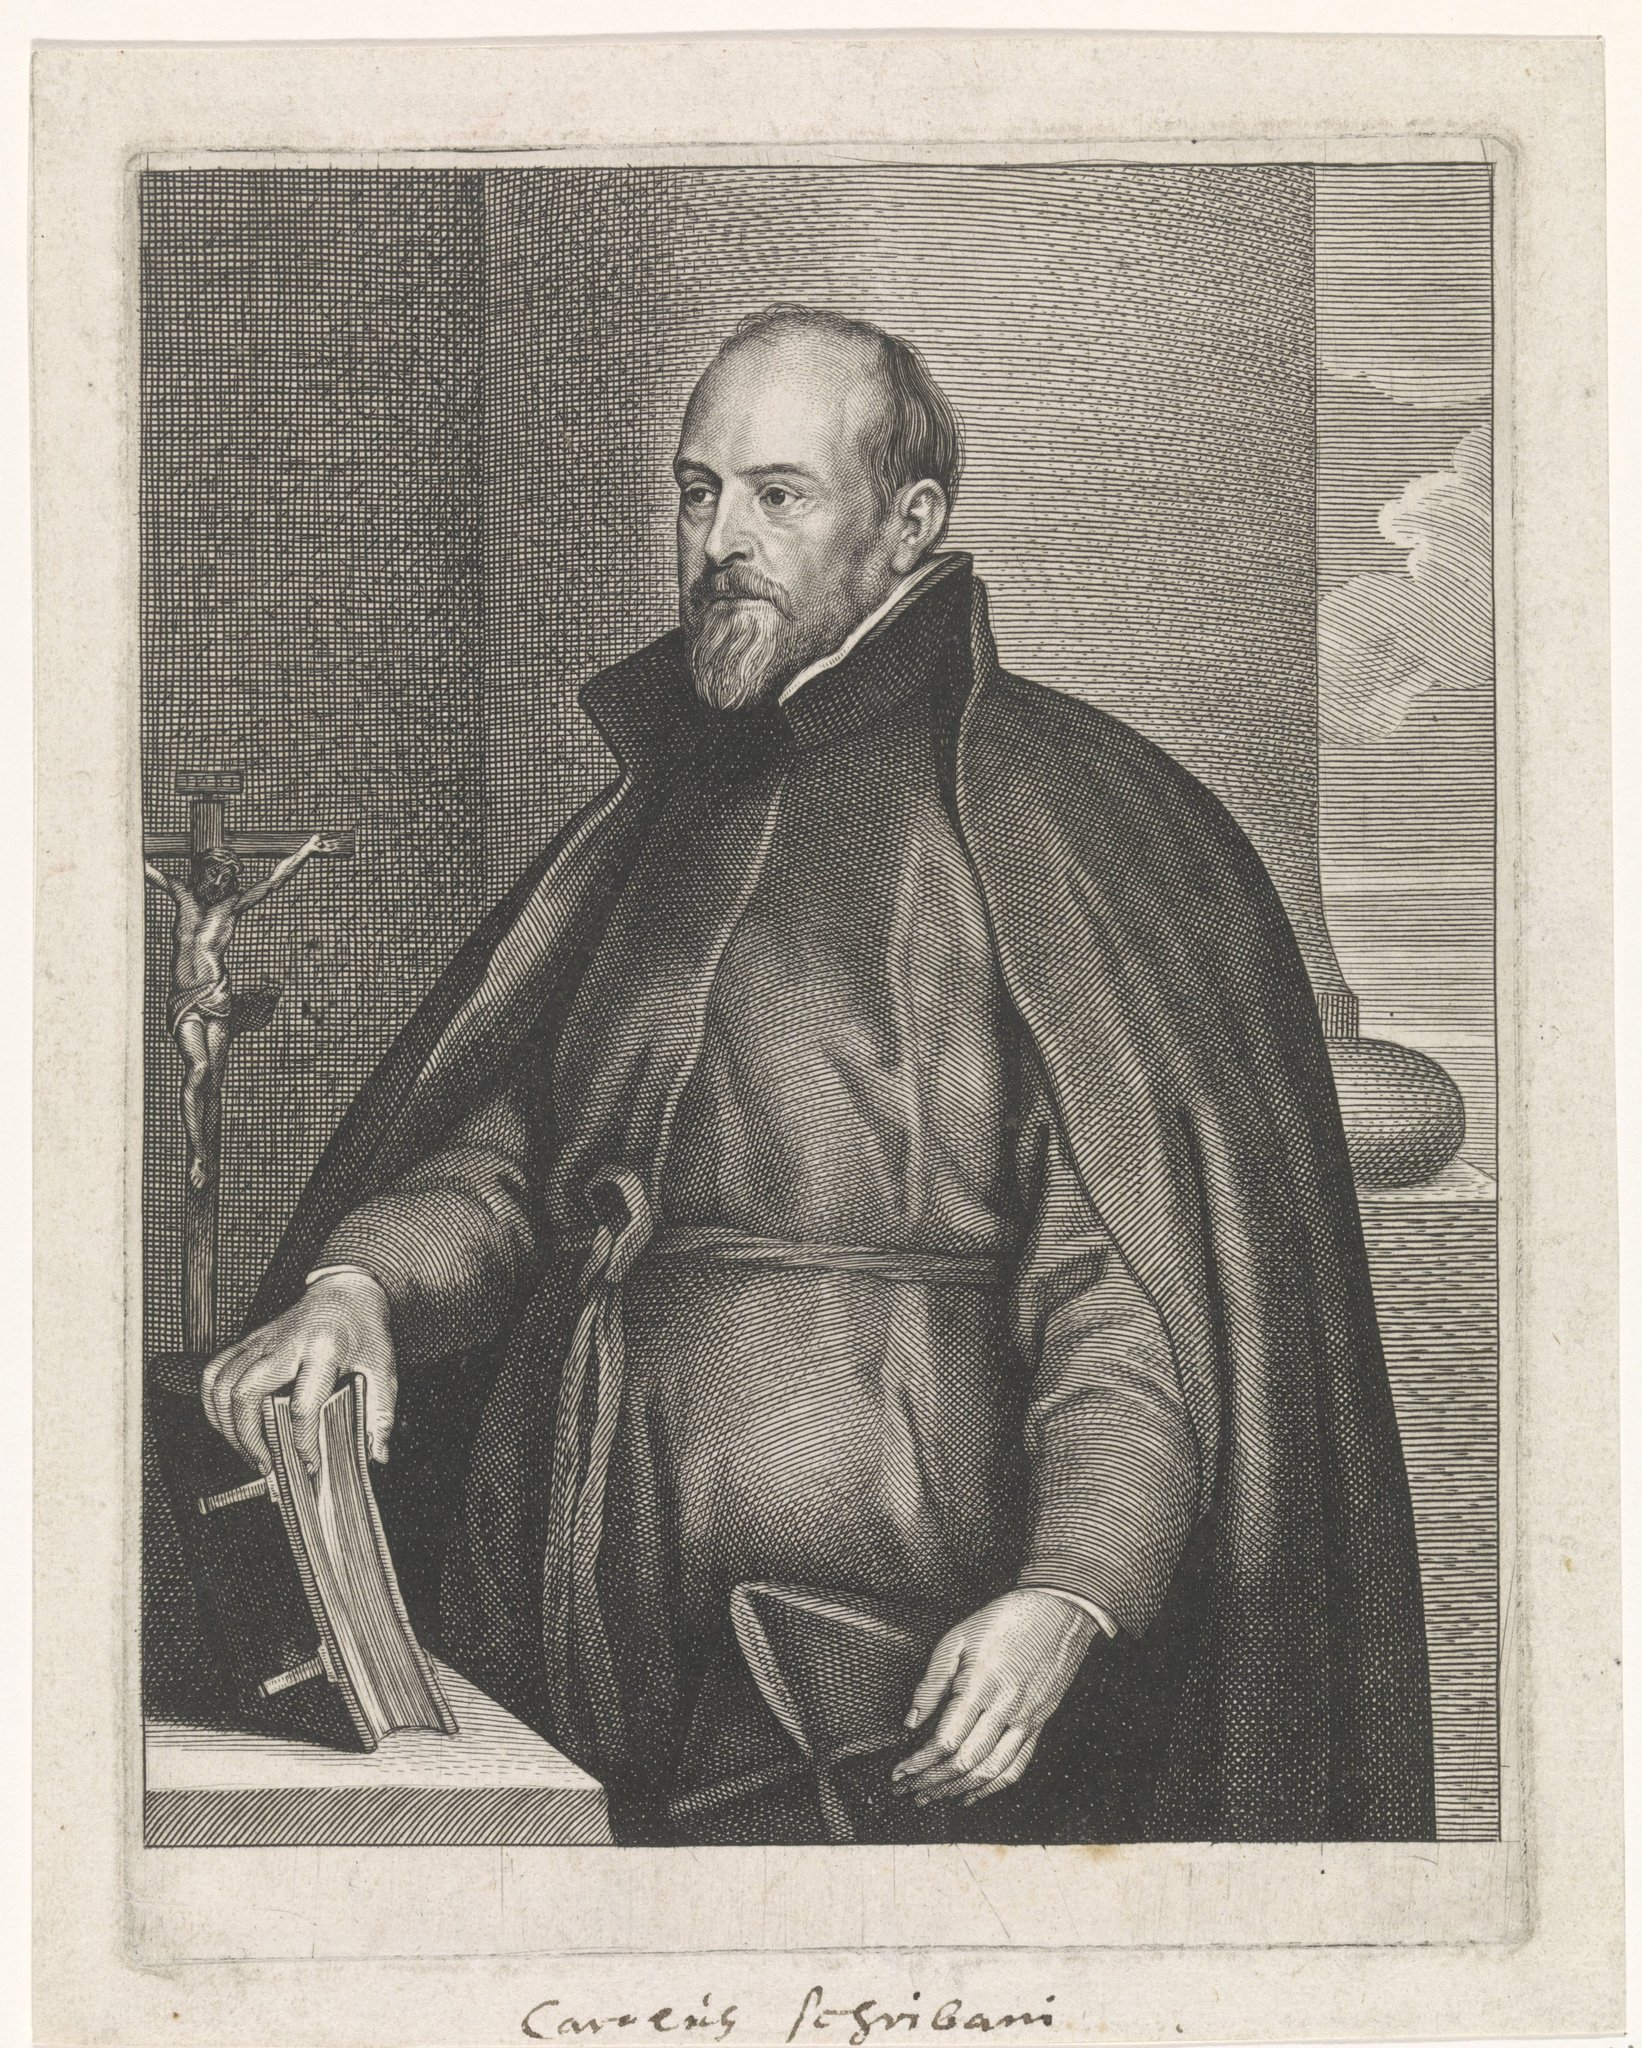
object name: print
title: Portret van de Jezuïet Carolus Scribani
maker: paulus pontius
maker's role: draughtsman, print maker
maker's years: 1603-1658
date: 1629-1657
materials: paper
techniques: engraving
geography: antwerp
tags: brussels, antwerp, priest, hierarchy of jurisdiction ~ roman catholic church, crucifix ~ personal devotion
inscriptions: collector's mark: Lugt 240, name: ‘Carolus Scribani’